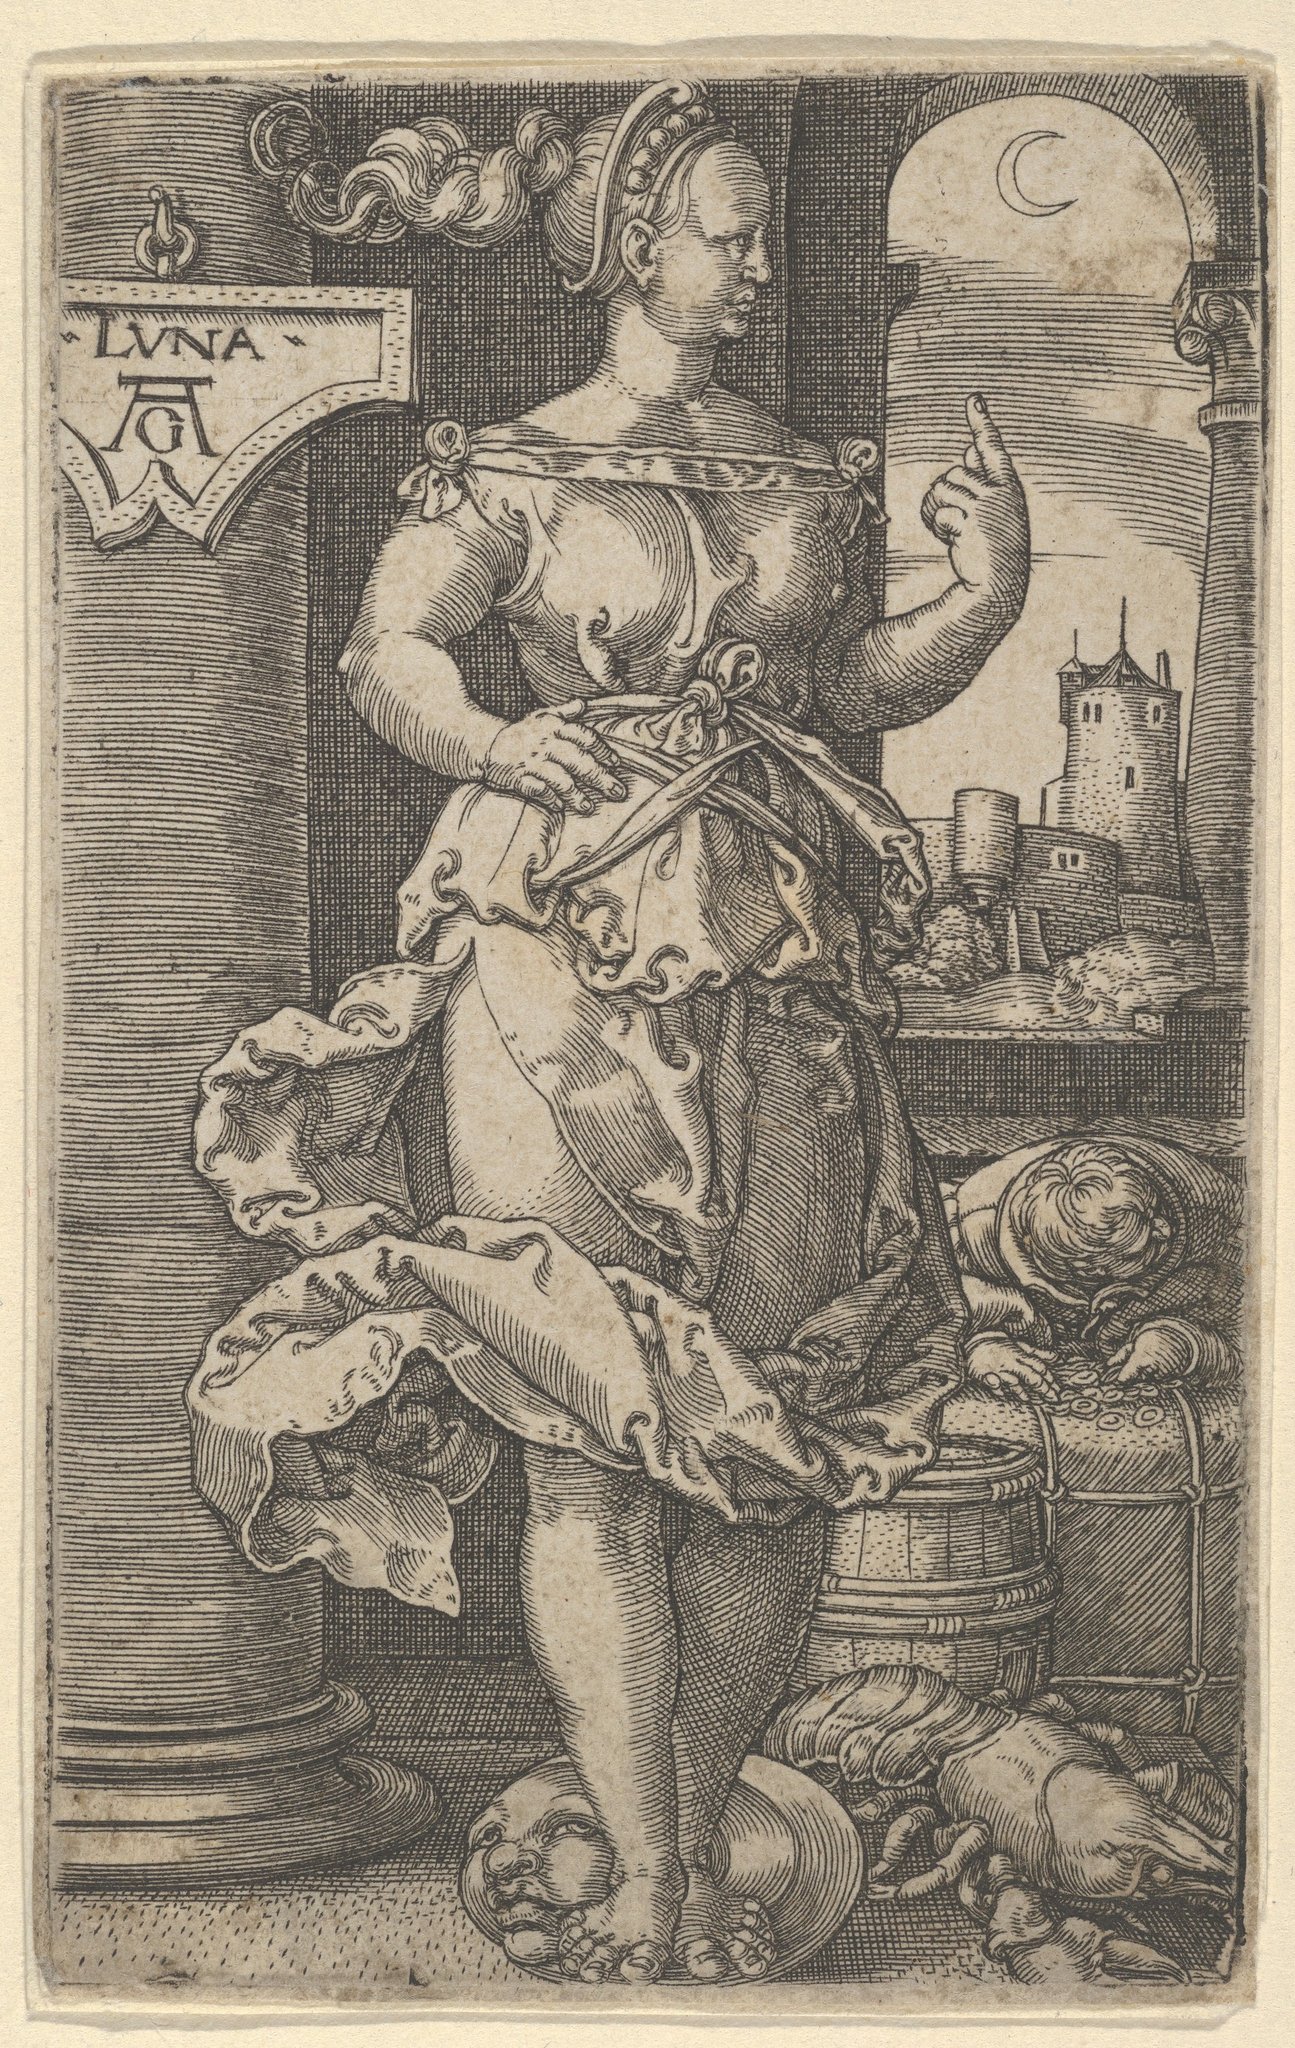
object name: print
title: Luna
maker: heinrich aldegrever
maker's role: artist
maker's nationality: german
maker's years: 1502-1561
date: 1533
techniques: engraving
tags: women